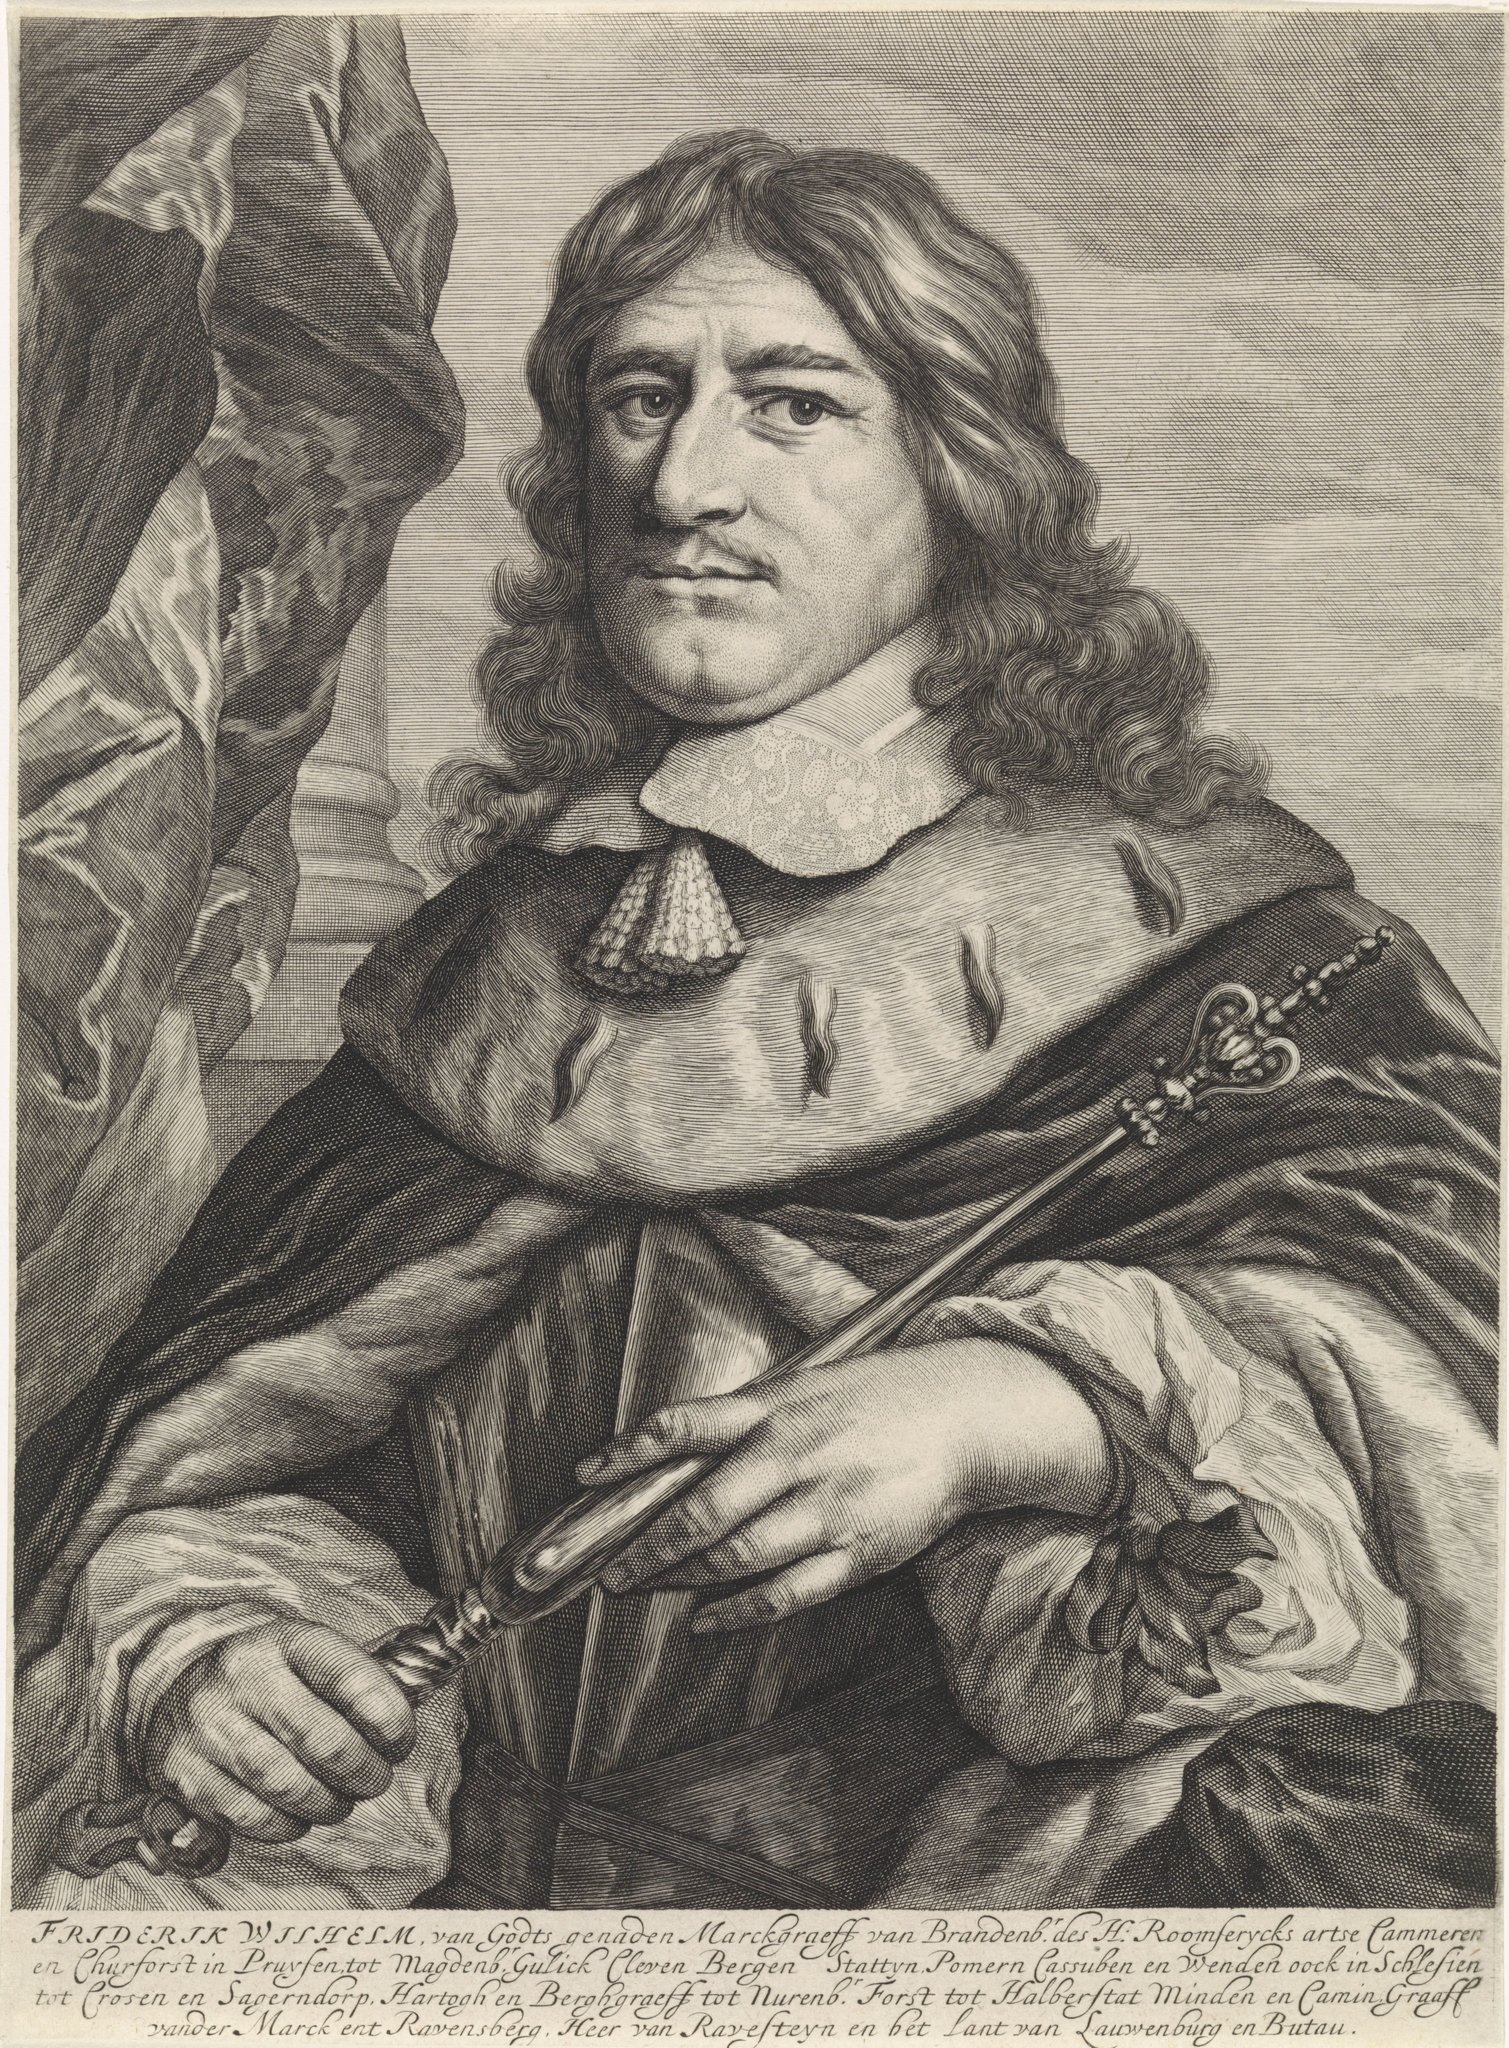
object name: print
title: Portret van Frederik Willem, keurvorst van Brandenburg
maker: theodor matham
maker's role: draughtsman, print maker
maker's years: 1605-1676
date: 1616-1676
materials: paper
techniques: engraving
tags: berlin, frederik willem van brandenburg (i), sceptre, staff (symbol of sovereignty)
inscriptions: collector's mark: Lugt 2228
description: Portret van Frederik Willem, keurvorst van Brandenburg met in zijn hand een scepter.